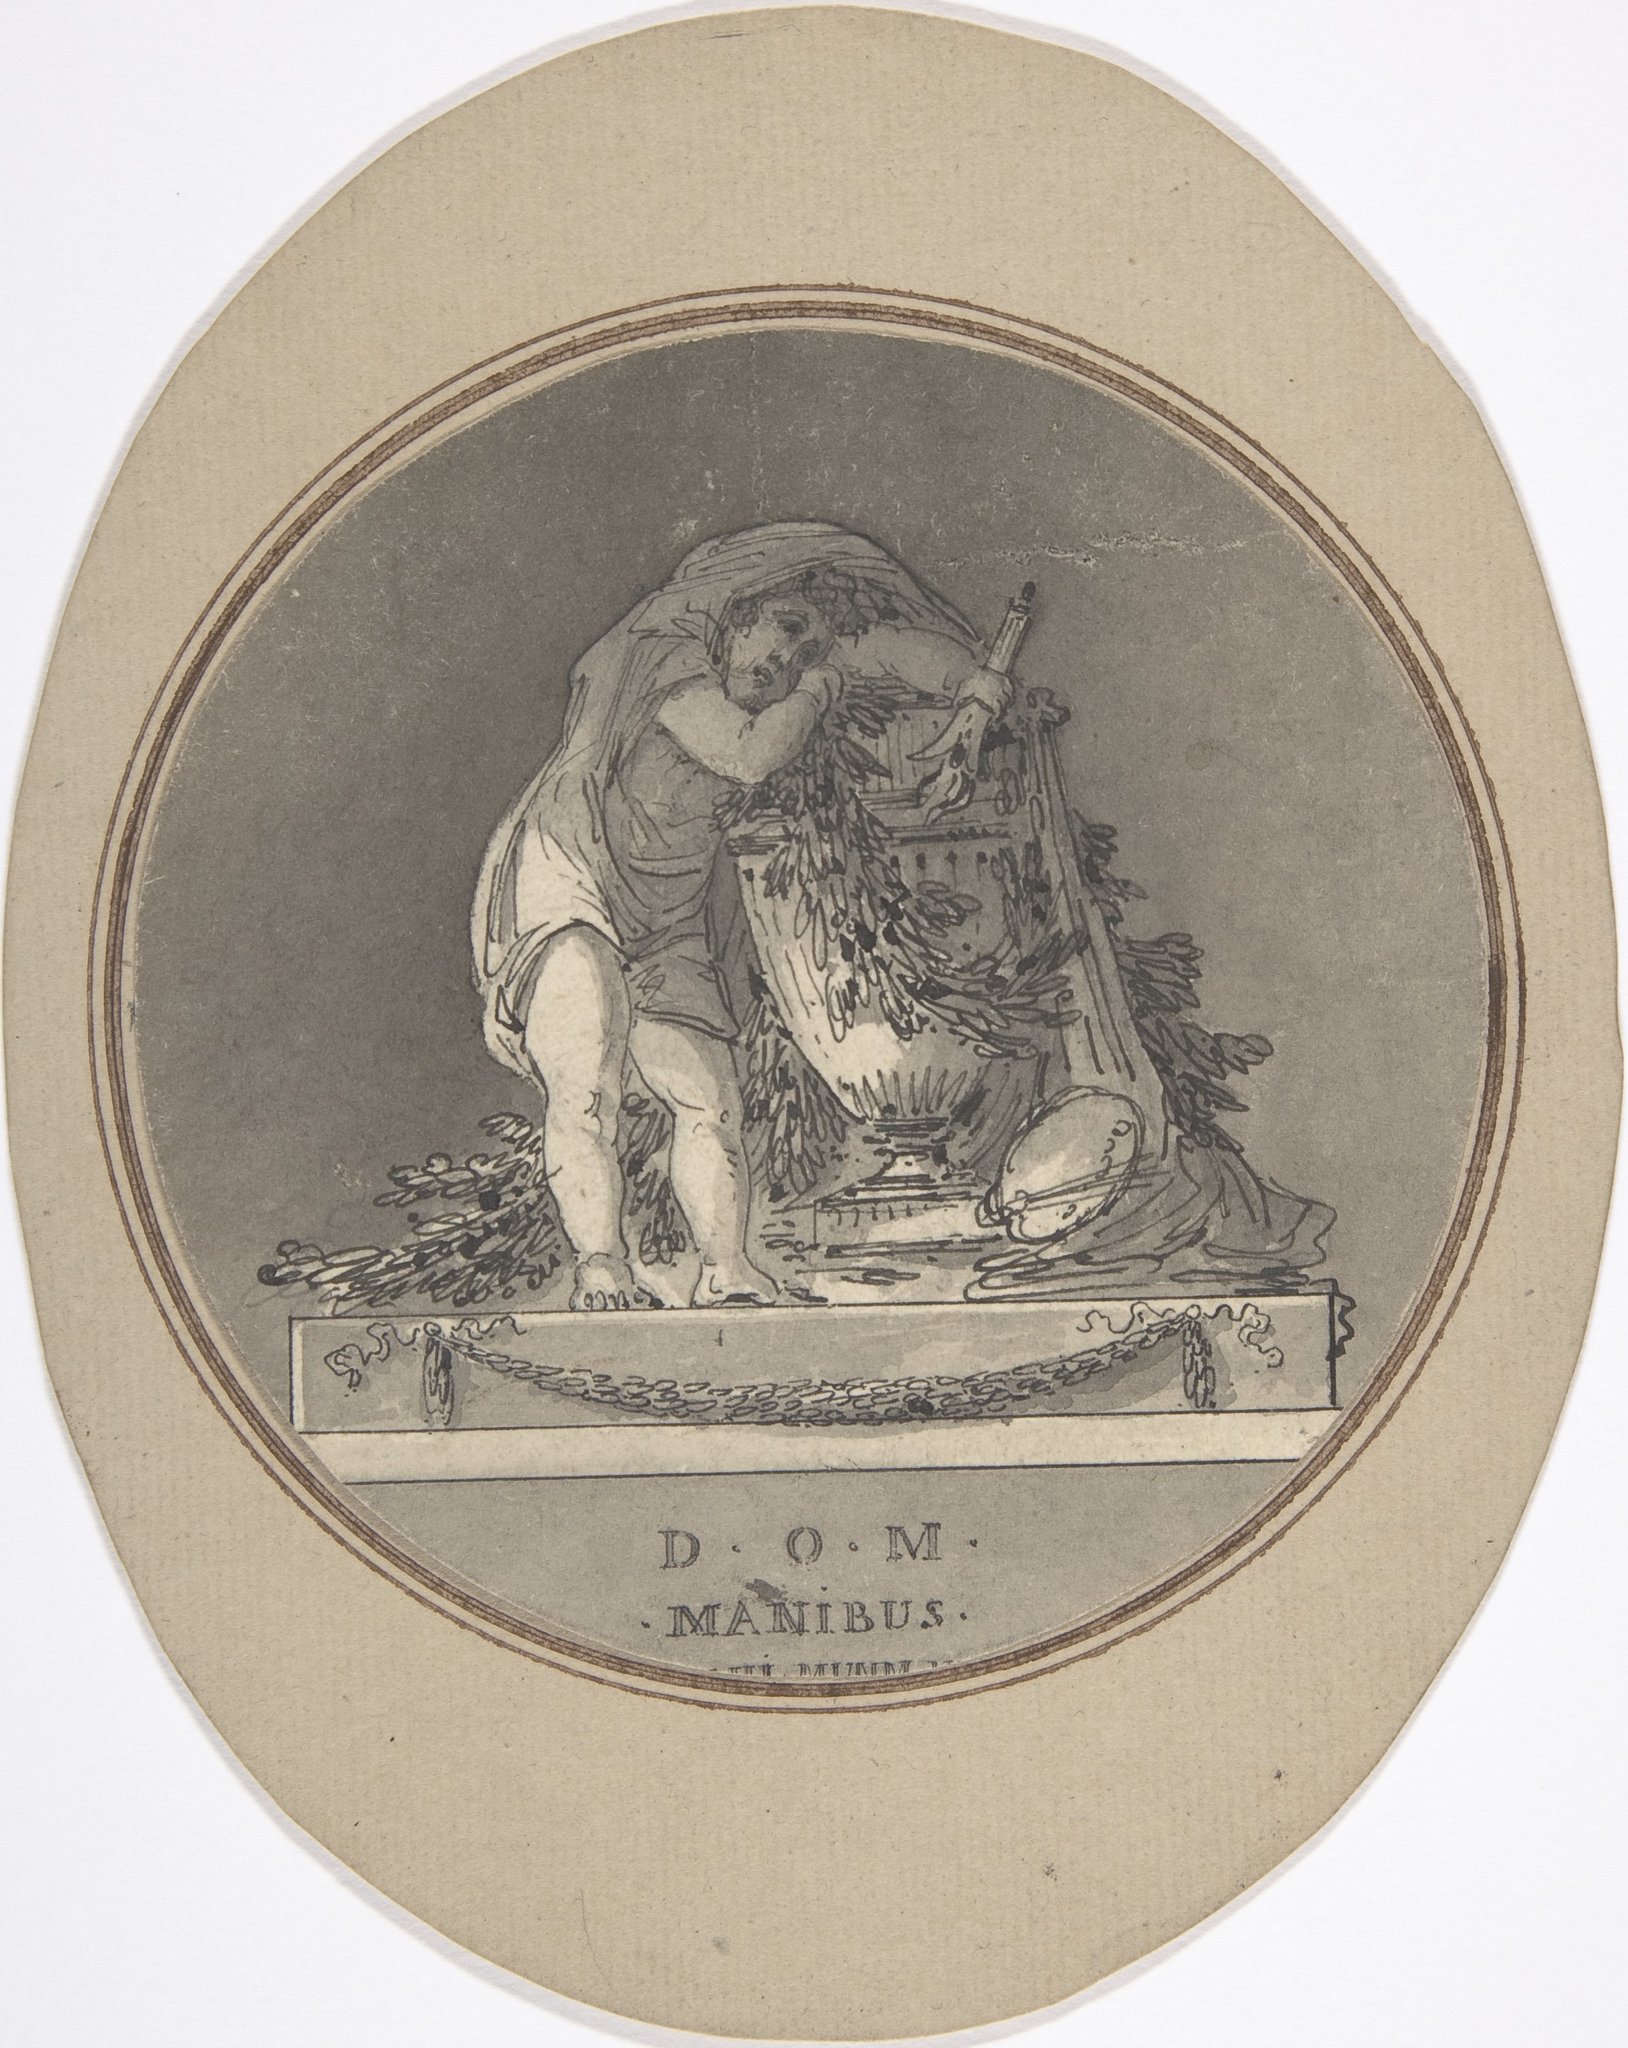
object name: drawing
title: Decoration for a Monument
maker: anonymous, french, 18th century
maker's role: artist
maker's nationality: french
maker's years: 1700-1800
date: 1701-1800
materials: ink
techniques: brush, pen, wash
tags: boys,plants